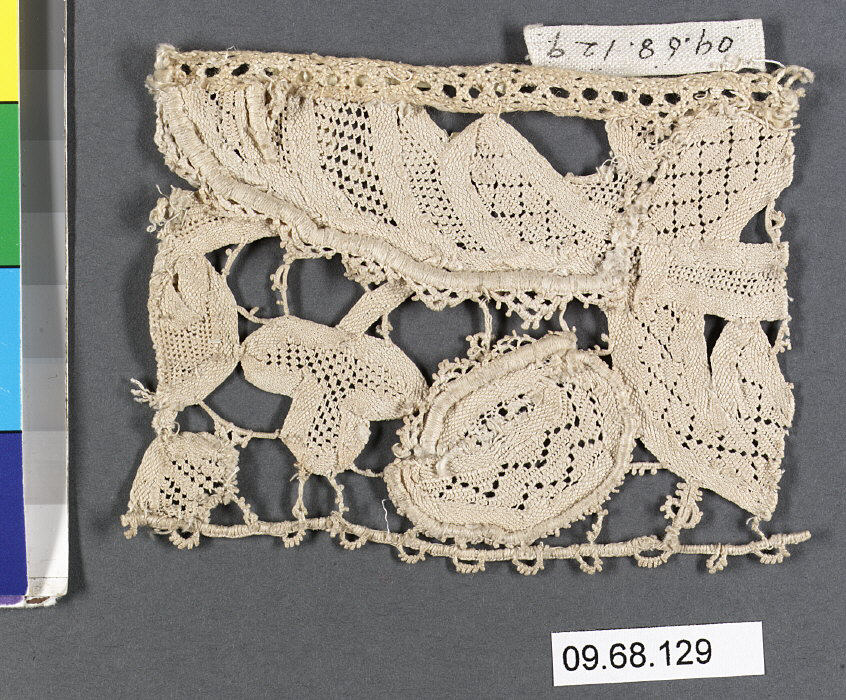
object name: fragment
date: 1601-1700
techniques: lace